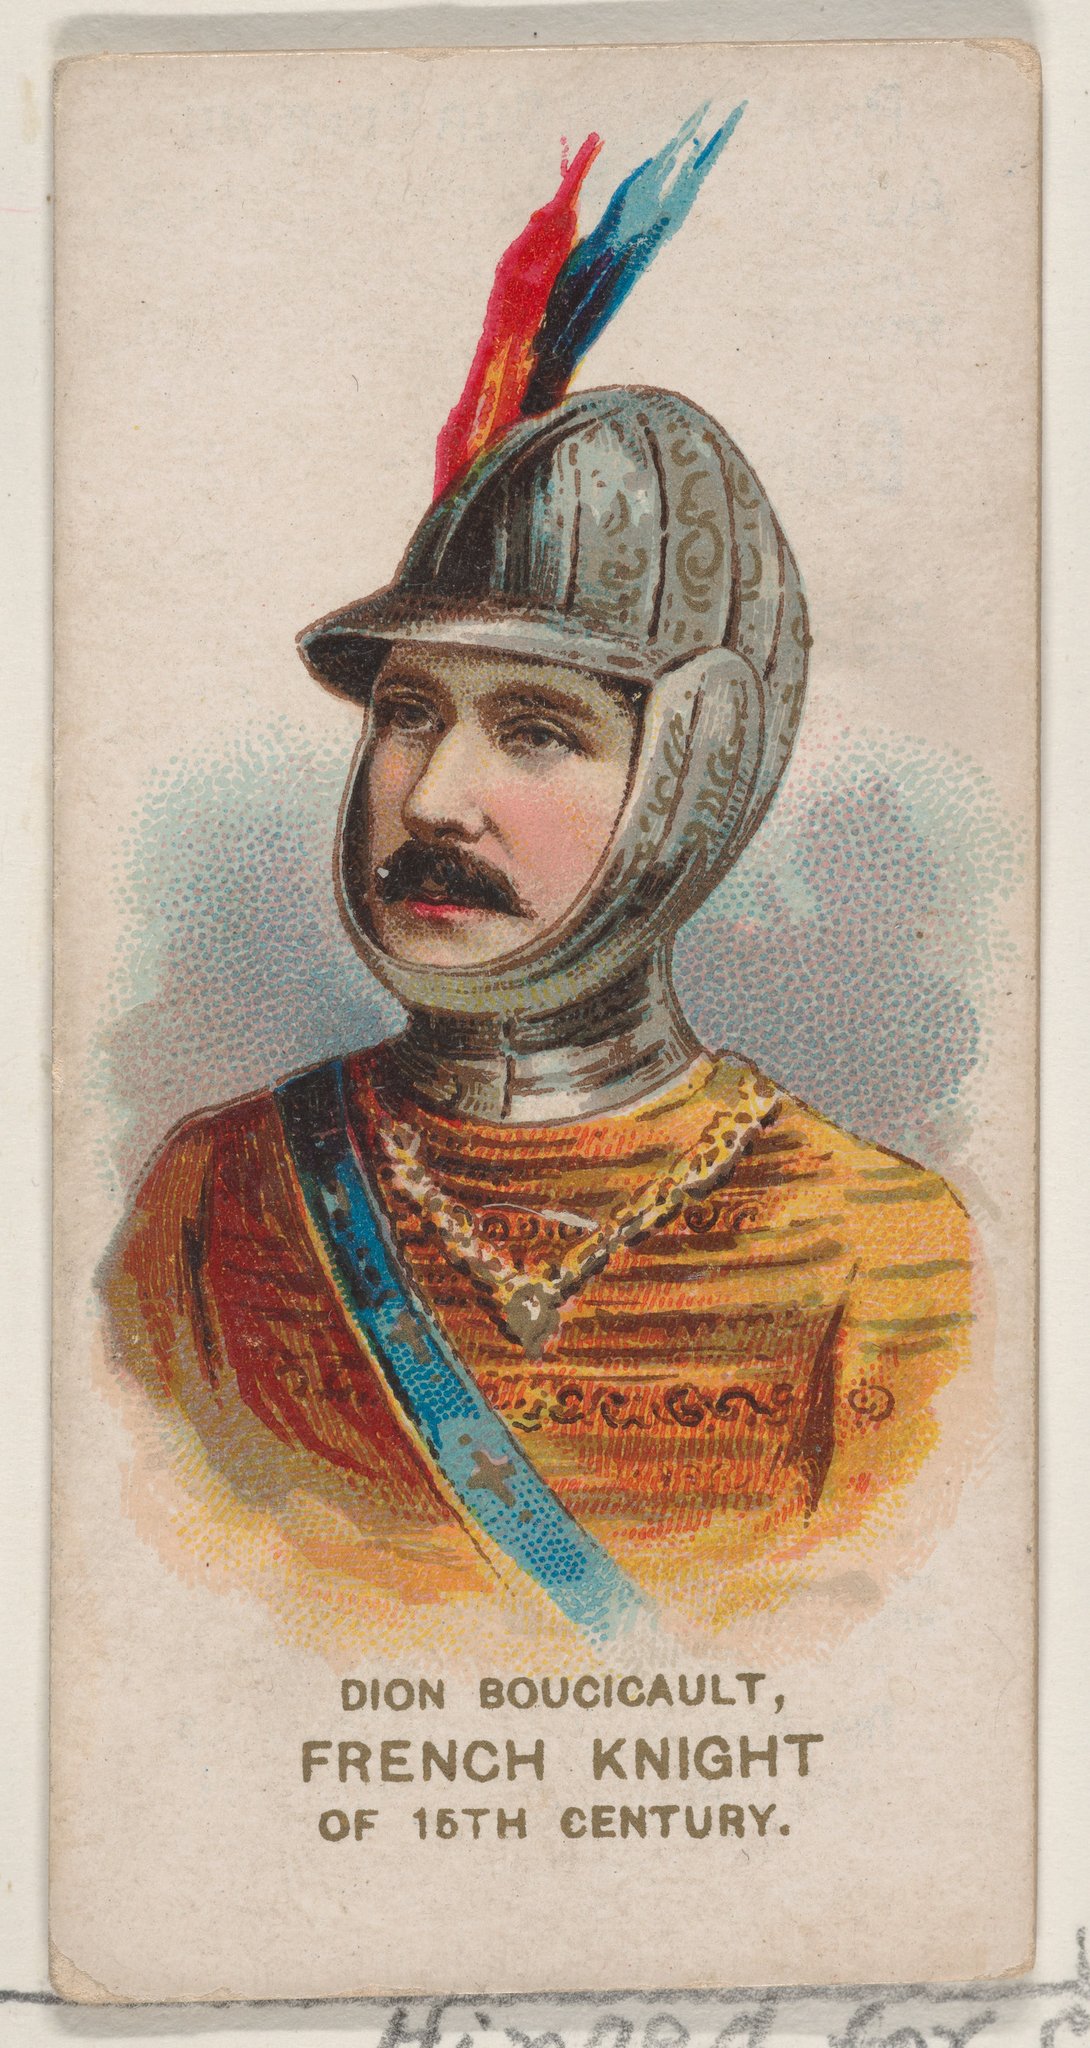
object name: print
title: Dion Boucicault as a French Knight of the 18th Century, from the set Actors and Actresses, First Series (N70) for Duke brand cigarettes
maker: w. duke, sons & co.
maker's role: publisher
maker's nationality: american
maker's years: 1870-1920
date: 1888-1889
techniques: color lithograph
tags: men,actors